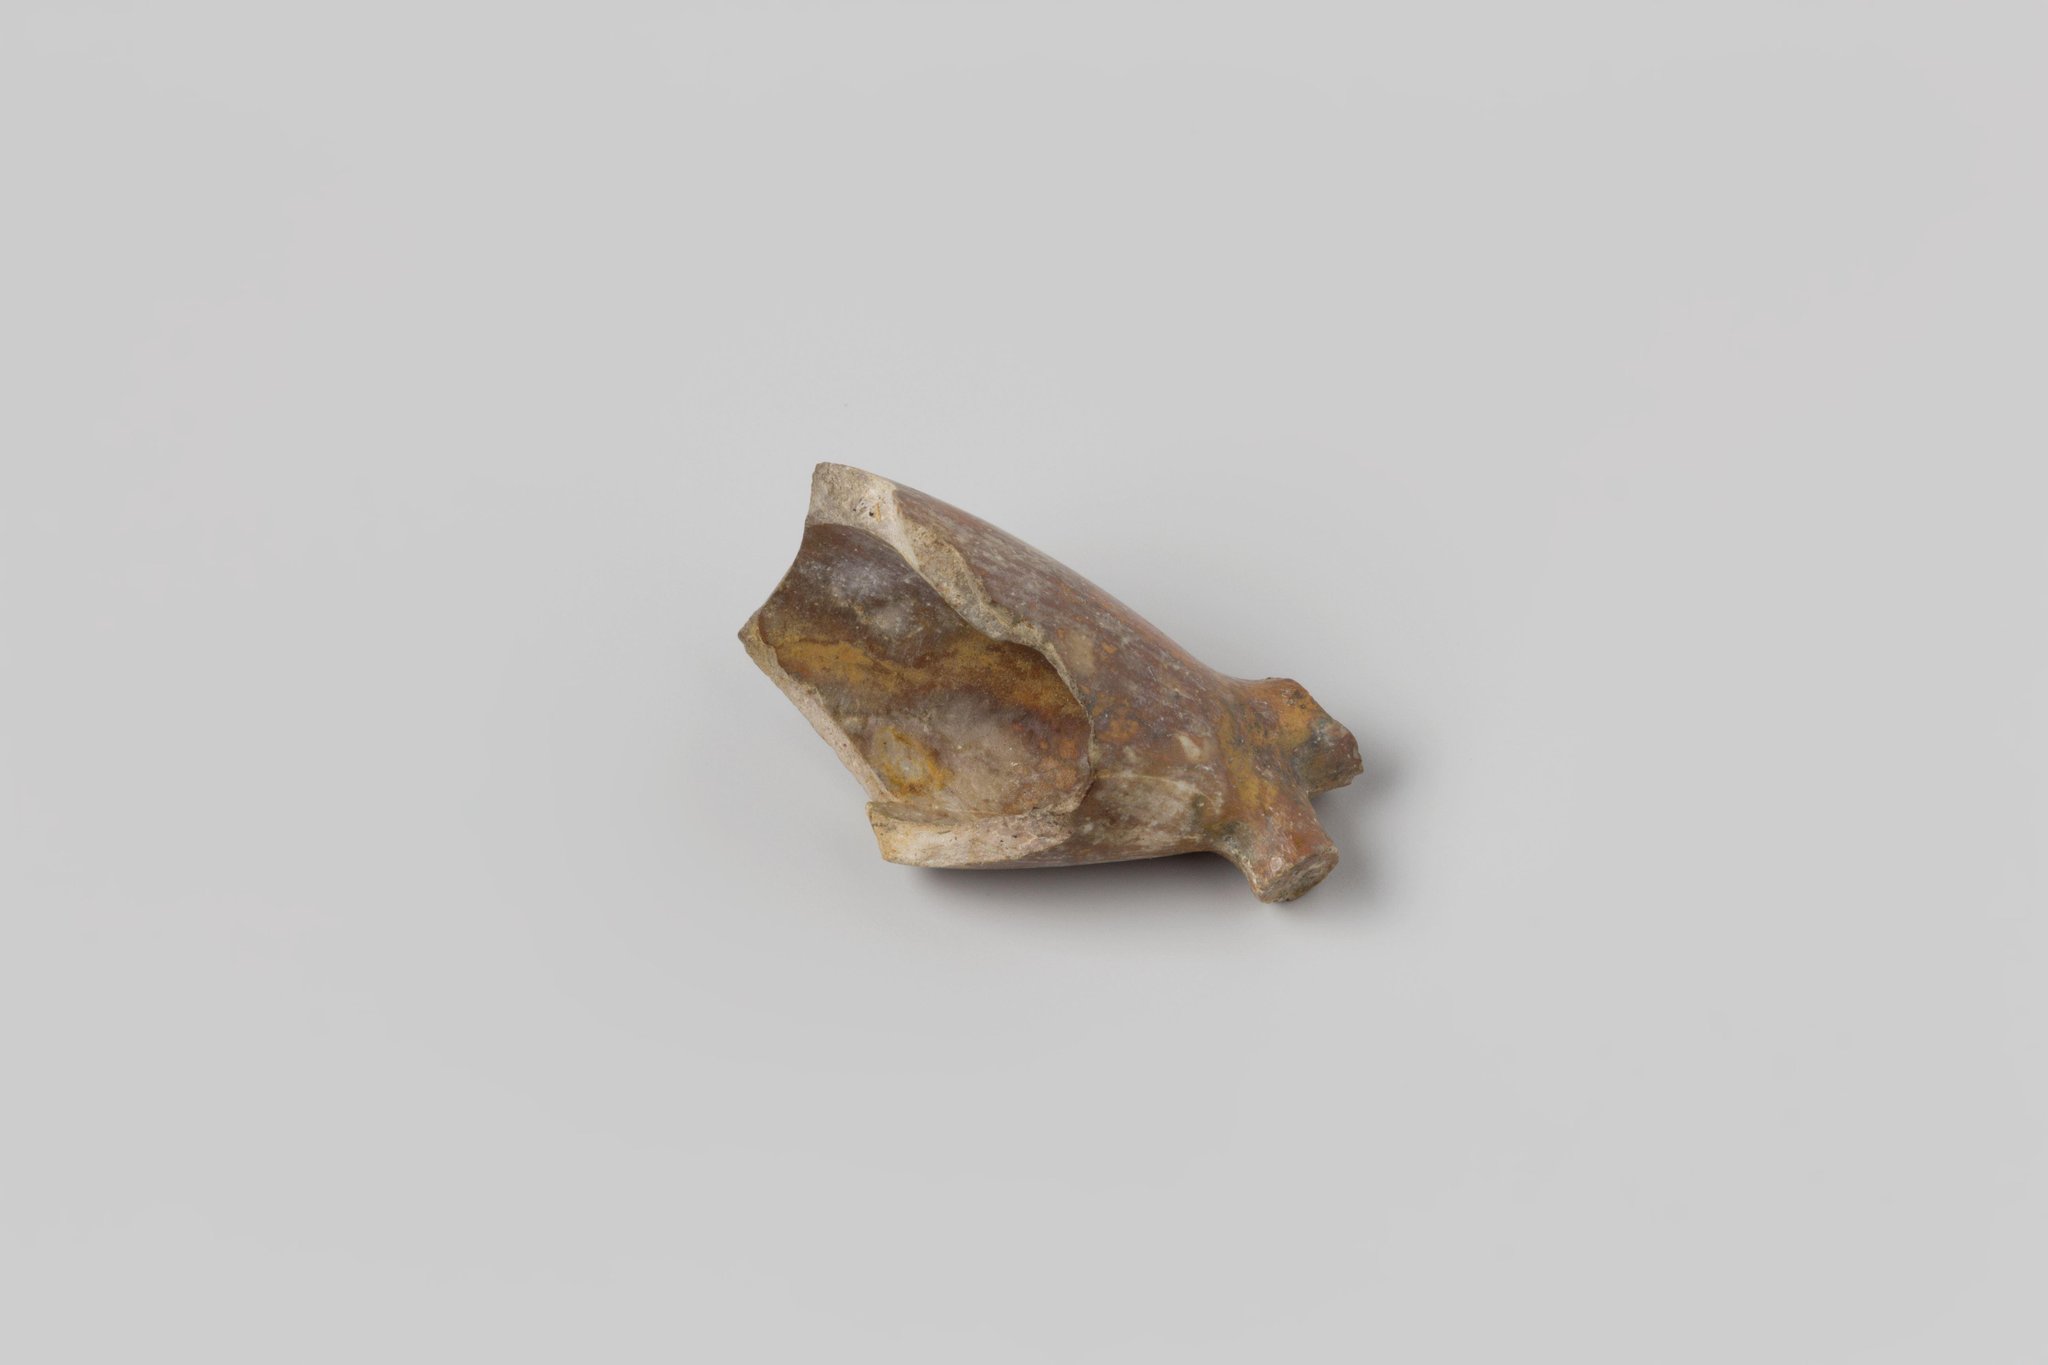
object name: pipe bowl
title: Fragment pijpenkop uit het wrak van de Oost-Indiëvaarder Hollandia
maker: Anonymous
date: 1700-1743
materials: clay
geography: netherlands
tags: verenigde oostindische compagnie, hollandia (schip), annet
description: Pipe, bowl, heelmark: crowned 57; fragment, no hsm.